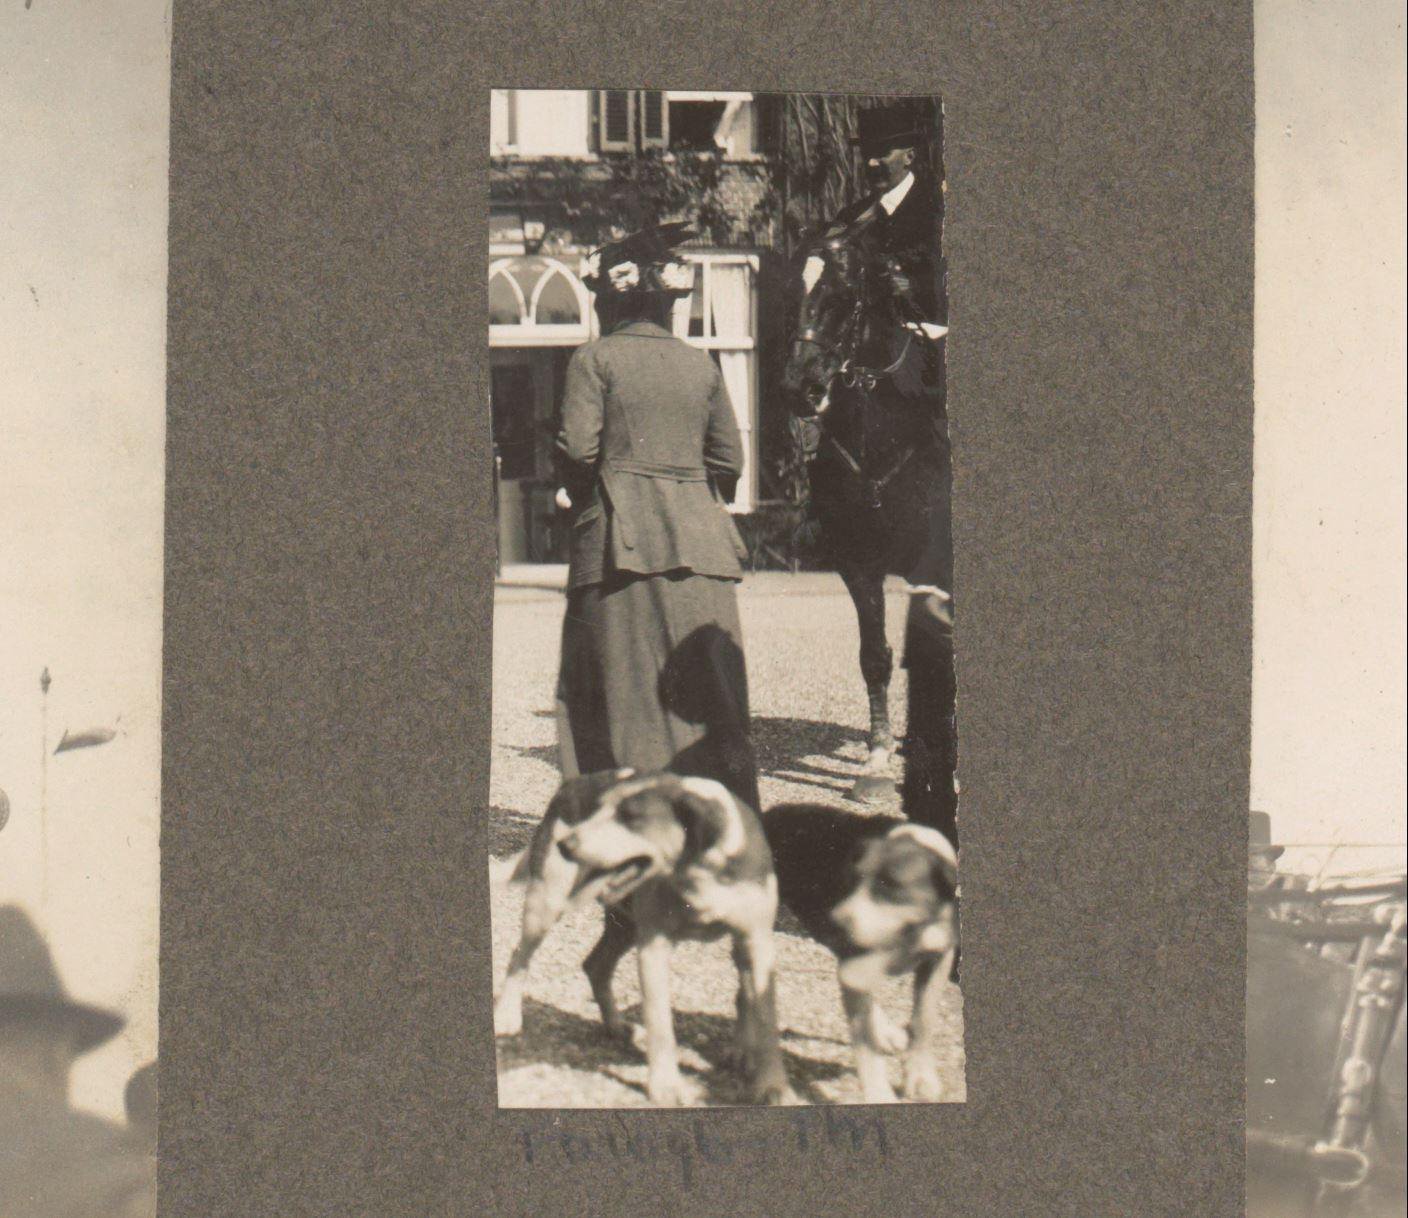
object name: photograph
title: Ruitertafereel op Koninklijke Houtvesterij Het Loo: vrouw, man te paard en honden in een tuin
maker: Anonymous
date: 1900-1925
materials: photographic support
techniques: gelatin silver print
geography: het loo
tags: riding a horse, ass, or mule; rider, horseman, hunting, chase, hunting dogs, hunting-ground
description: Onderdeel van Fotoalbum van de heer Brams, opperhoutvester van koningin Wilhelmina op Koninklijke Houtvesterij Het Loo.